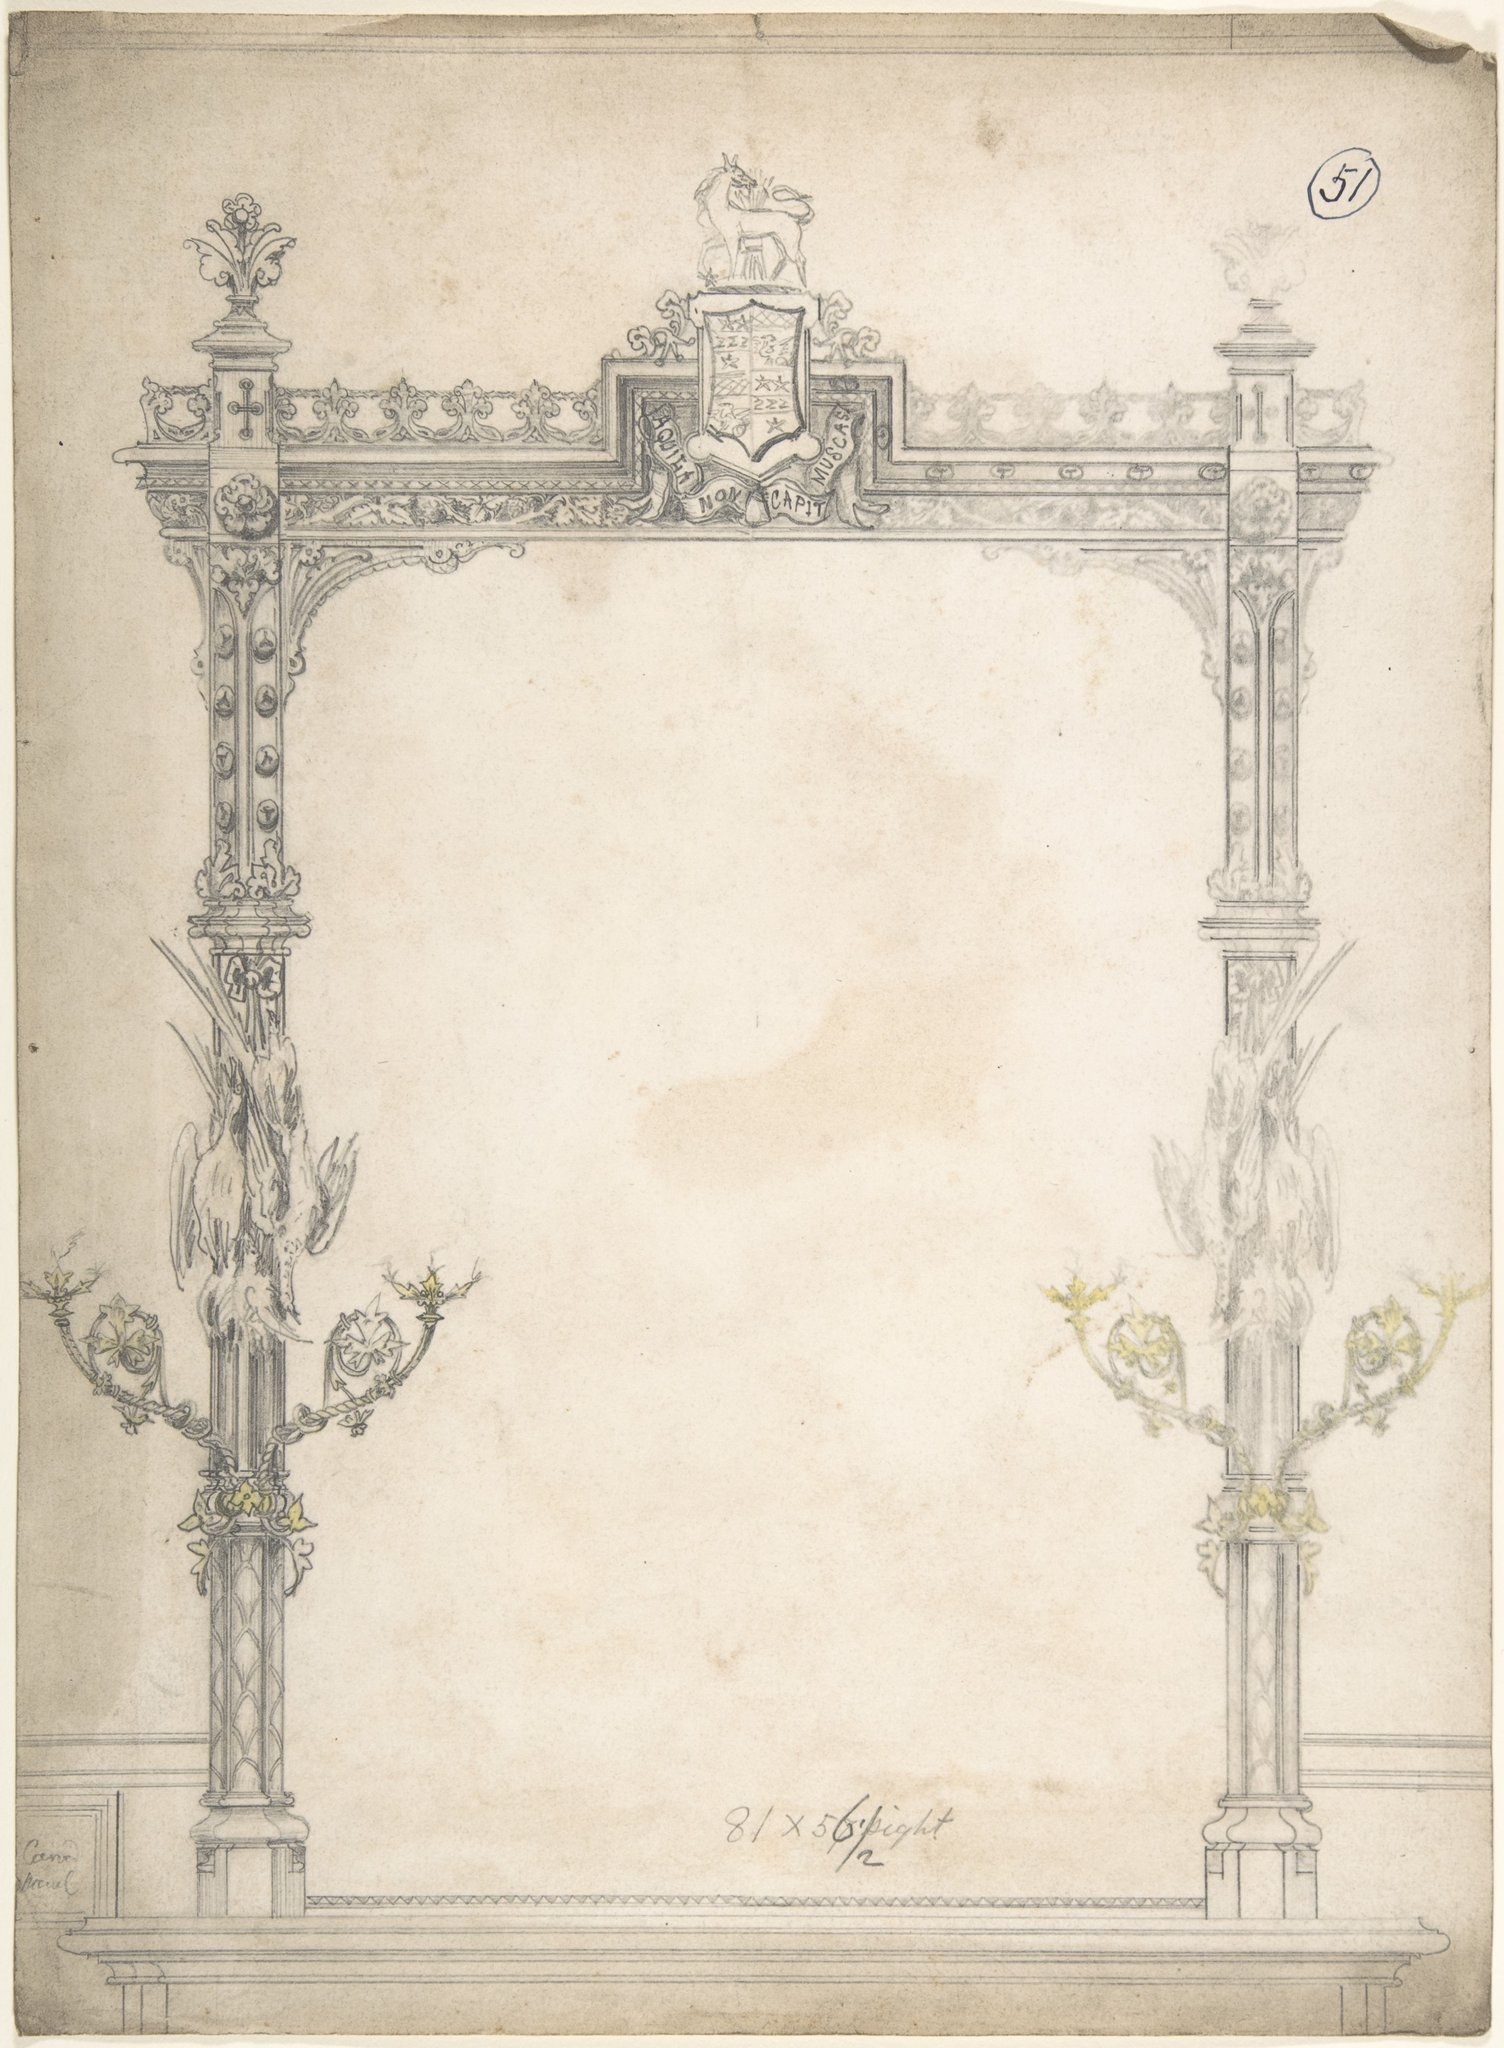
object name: drawing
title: Design for a Mirror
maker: charles hindley and sons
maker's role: artist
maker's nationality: british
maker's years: 1841-1917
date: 1841-1900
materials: graphite, watercolor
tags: horses,coat of arms,mirrors